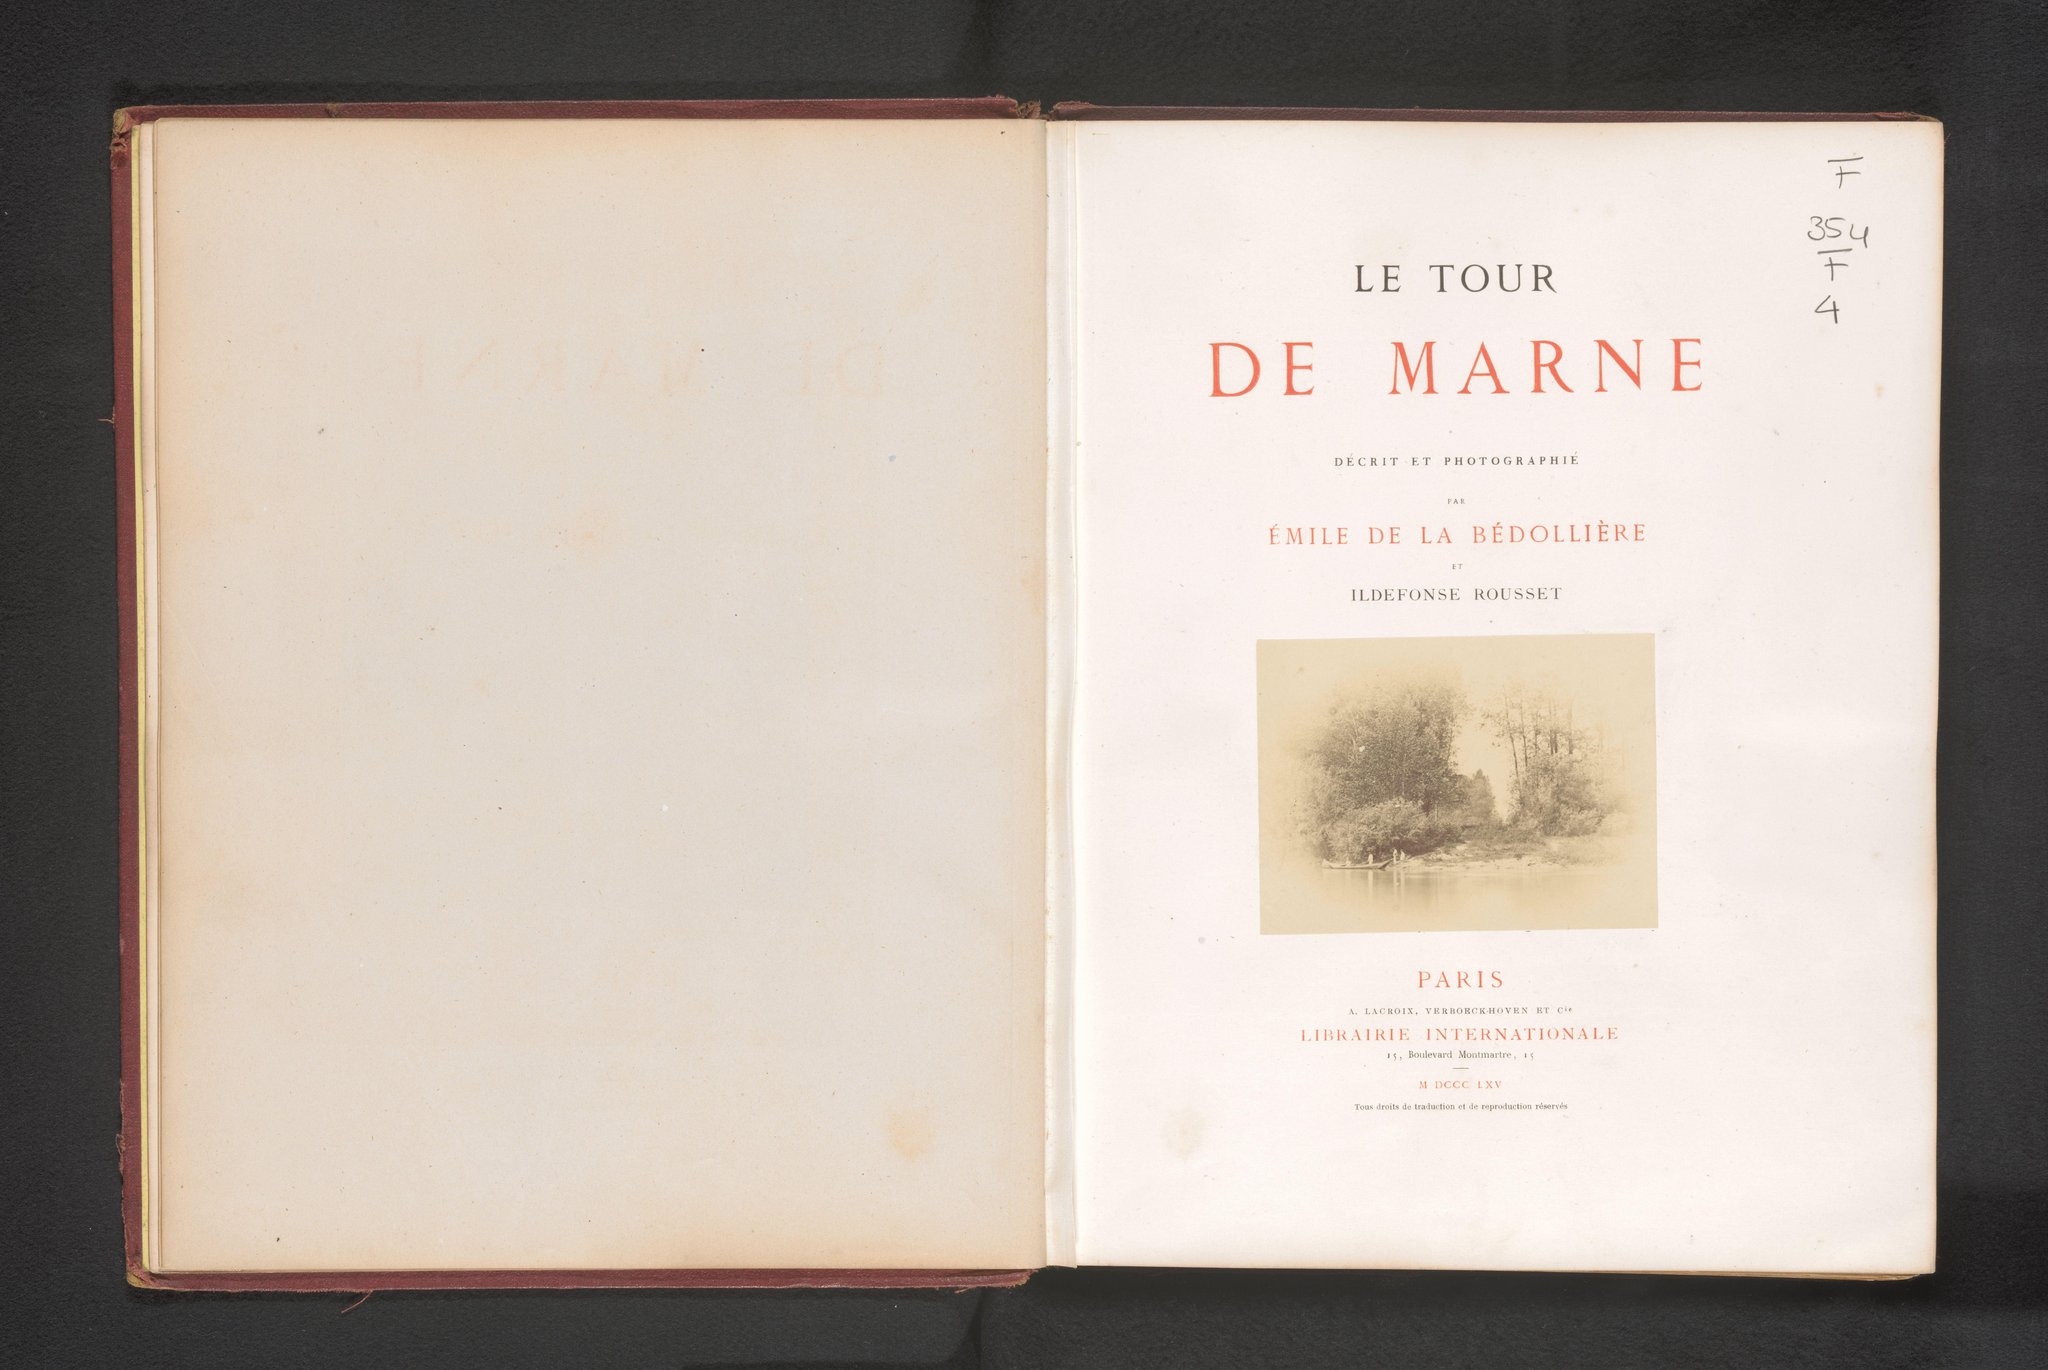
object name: page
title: Schepen op de Marne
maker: ildefonse rousset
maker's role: fotograaf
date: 1860-1865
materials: photographic support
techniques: albumen print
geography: france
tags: river, ships (in general), working class, labourers